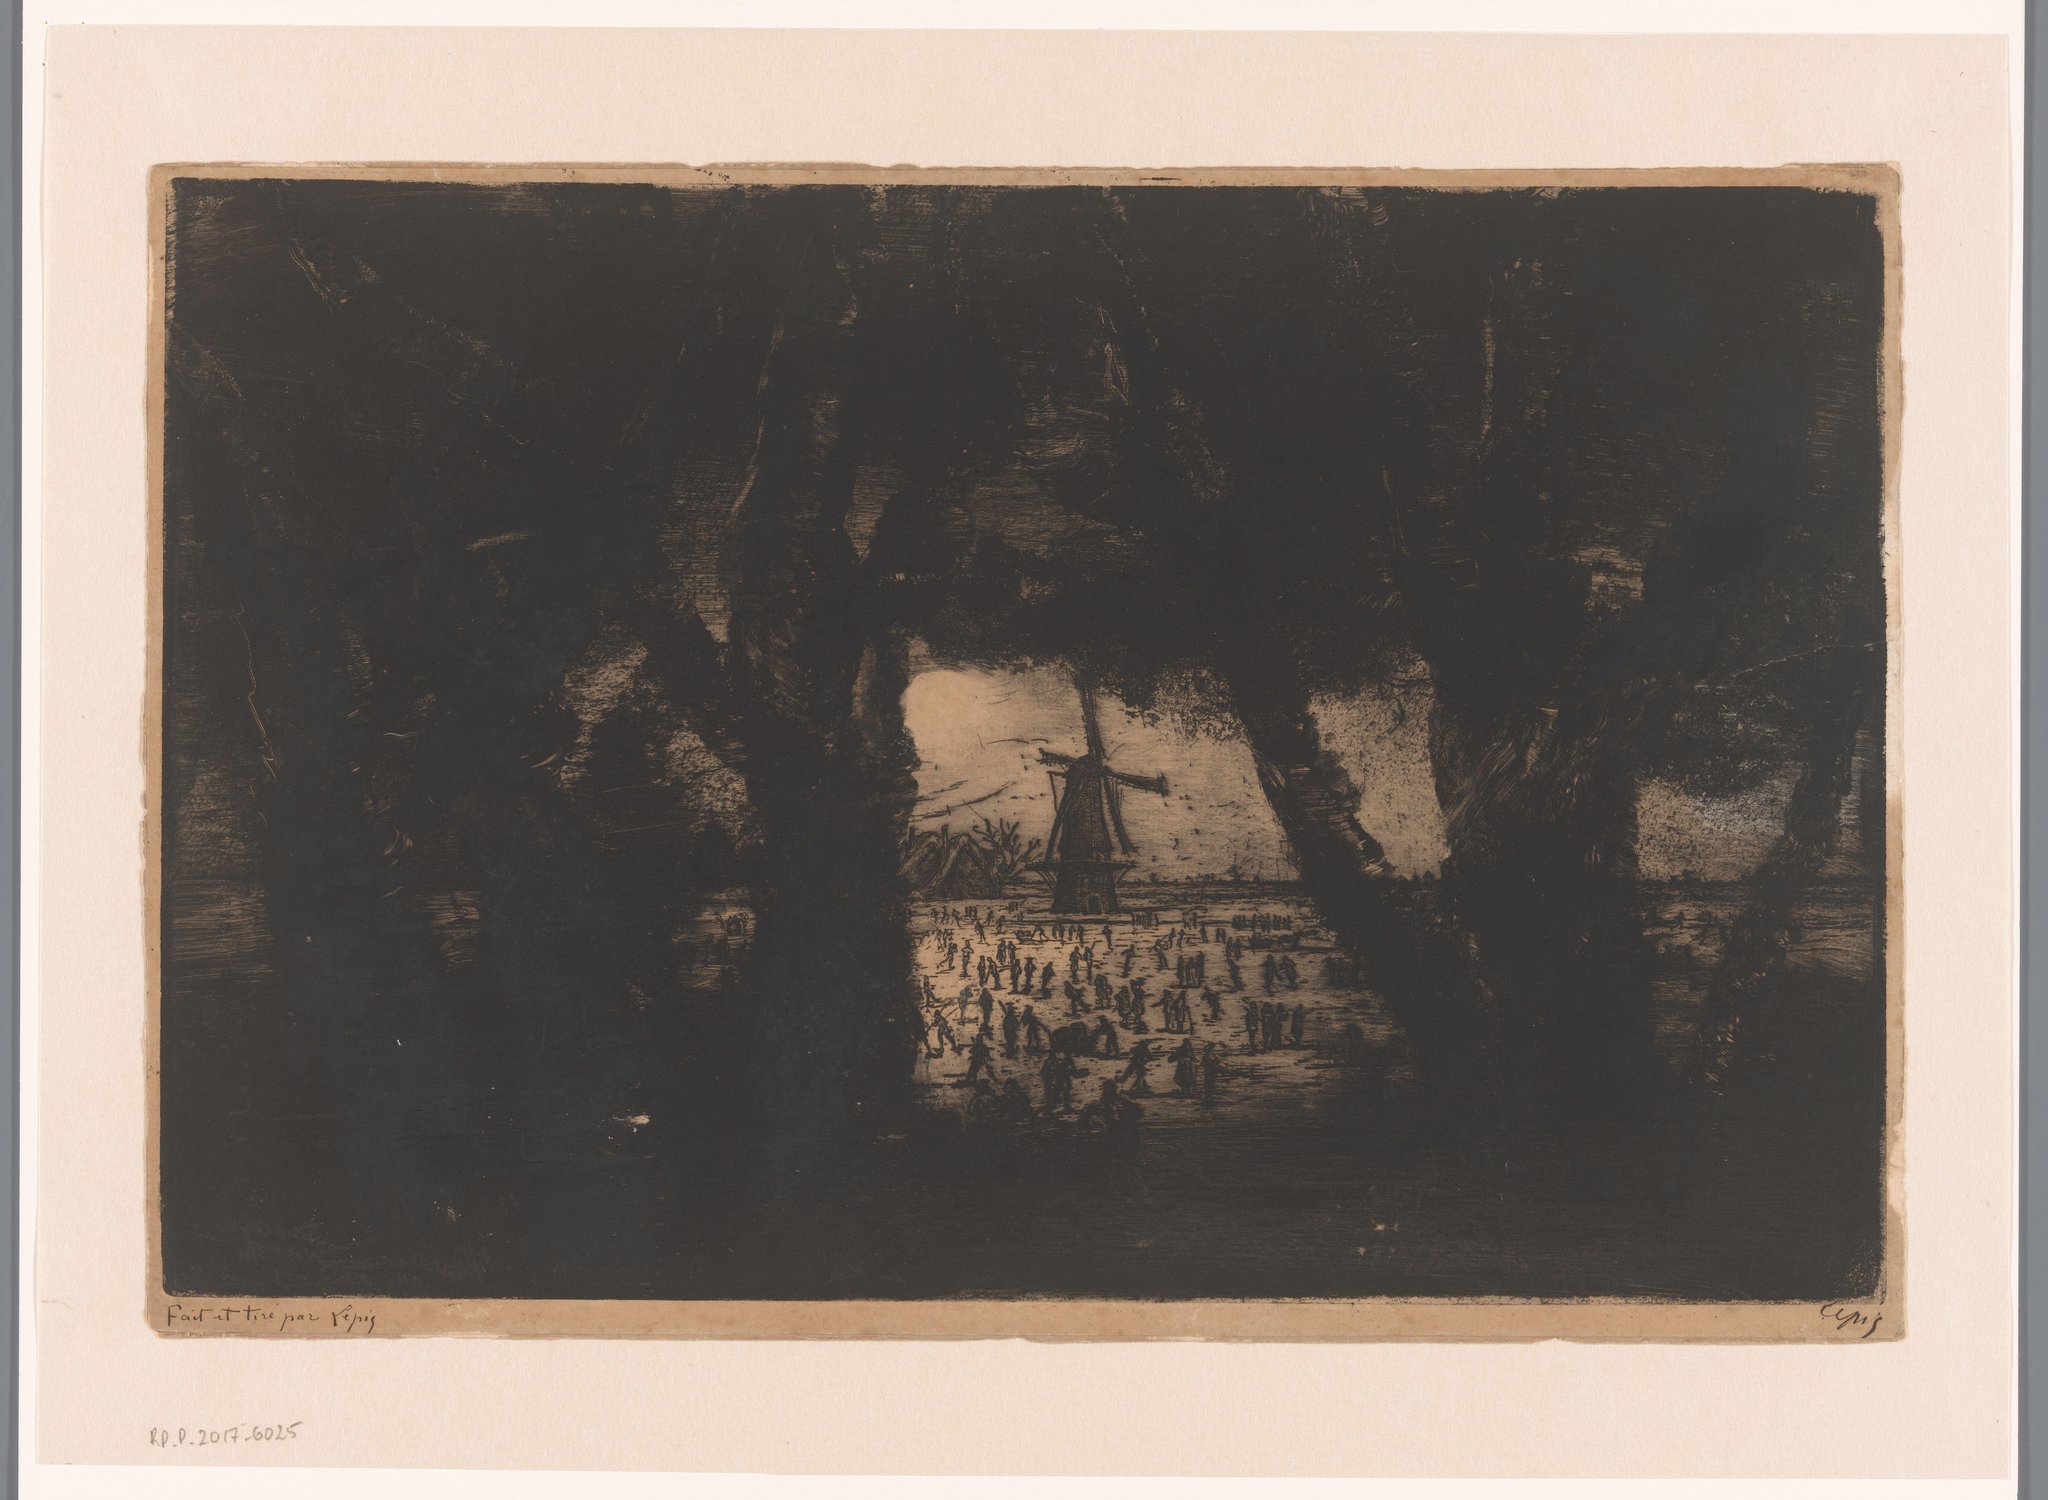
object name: print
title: Dutch Winter Landscape with Windmills and Skaters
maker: ludovic napoléon lepic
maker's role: print maker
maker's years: 1839-1889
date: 1870-1880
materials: paper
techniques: etching, intaglio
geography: france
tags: landscapes in the temperate zone, windmill in landscape, skates (winter sports), netherlands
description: Ludovic Napoléon Lepic is one of the original French Impressionists. He painted, but was also an innovative printmaker. He only deemed an etching to be art when the printmaker printed his own copper plate and inked it in different ways. He called this method ‘l’eau-forte mobile,’ or variable etching. The impressions displayed here demonstrate what he meant. The differences are exclusively due to various ways of inking the plate.